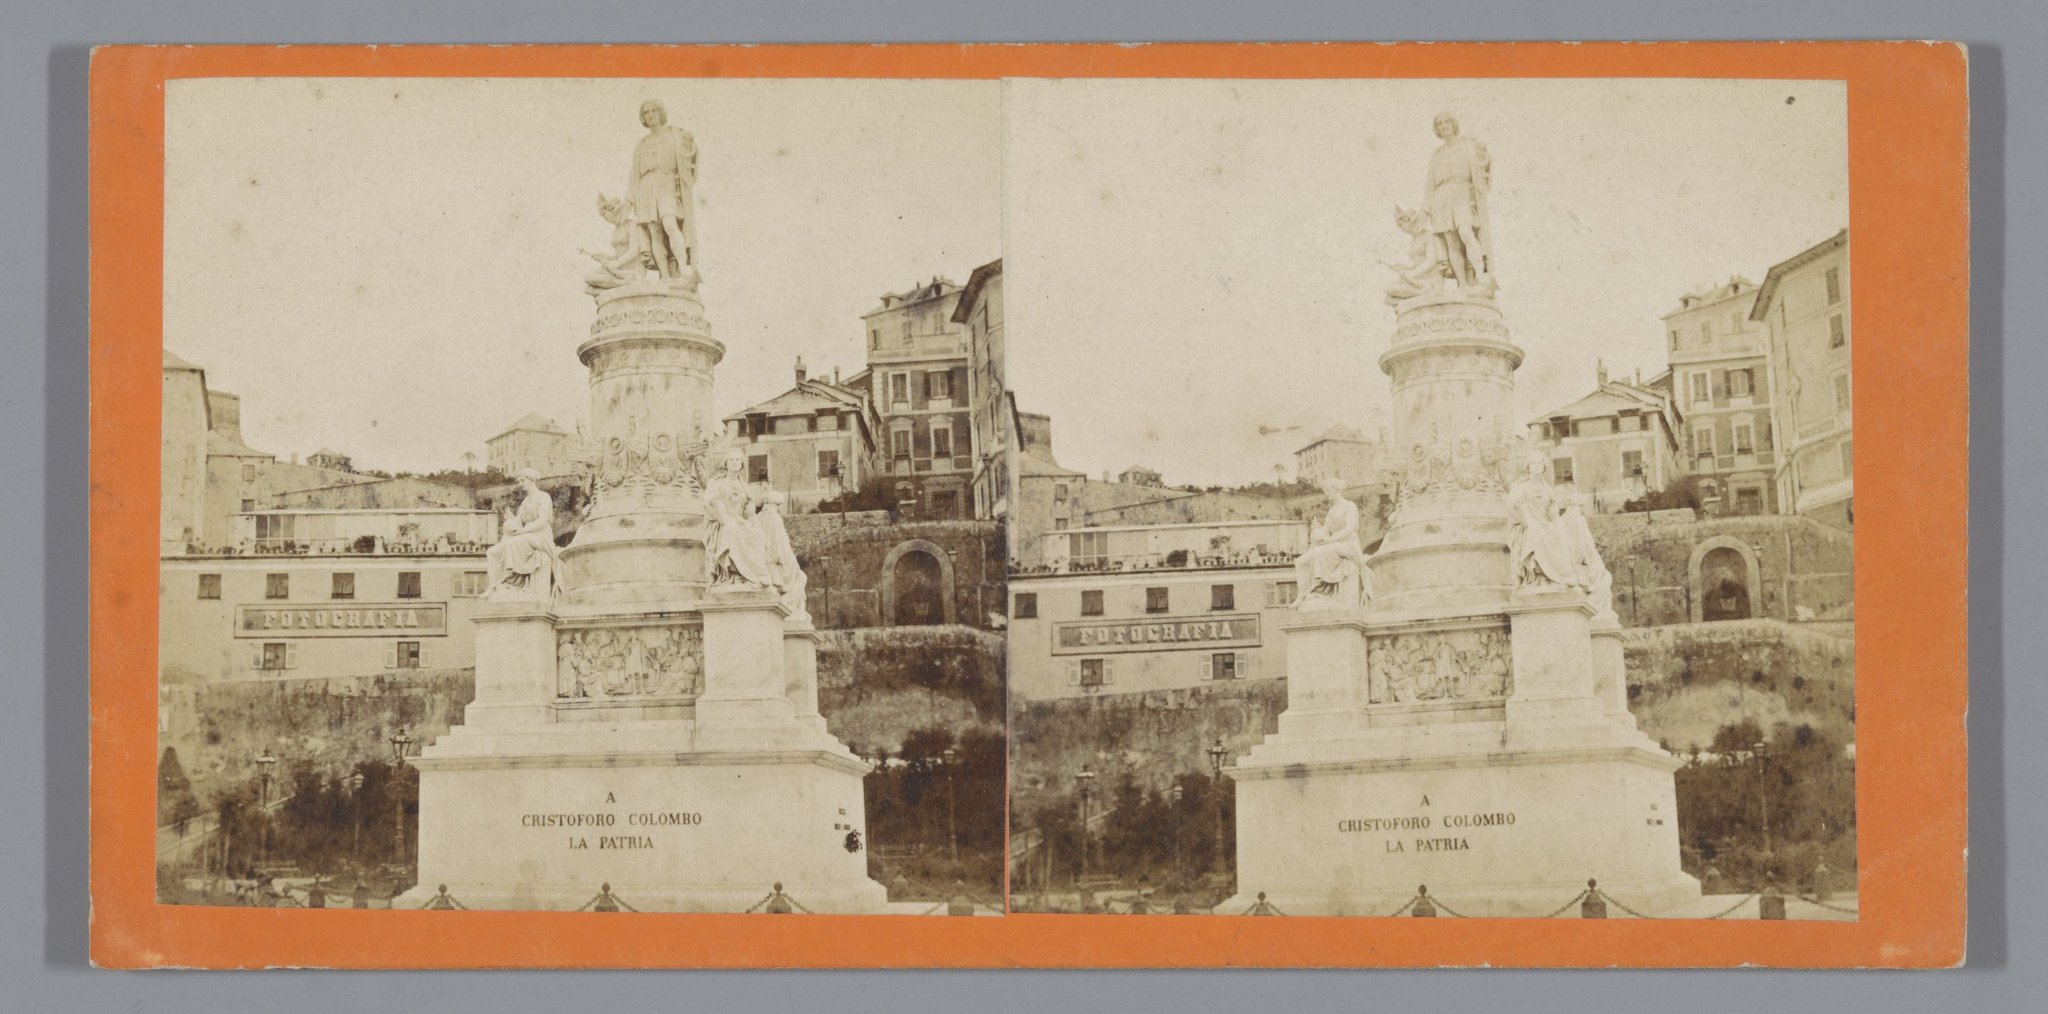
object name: stereograph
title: Monument van Christoffel Columbus te Genua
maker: Anonymous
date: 1850-1880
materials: cardboard, photographic support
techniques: albumen print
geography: genoa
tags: monument, statue, sculpture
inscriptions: inscription: ‘Genova Cristoforo Colombo’